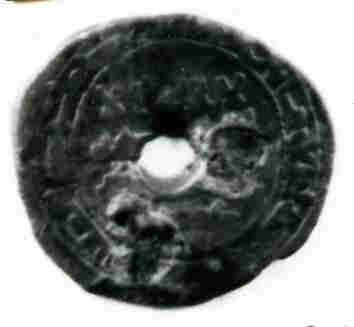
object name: coin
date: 204-819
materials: copper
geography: iran